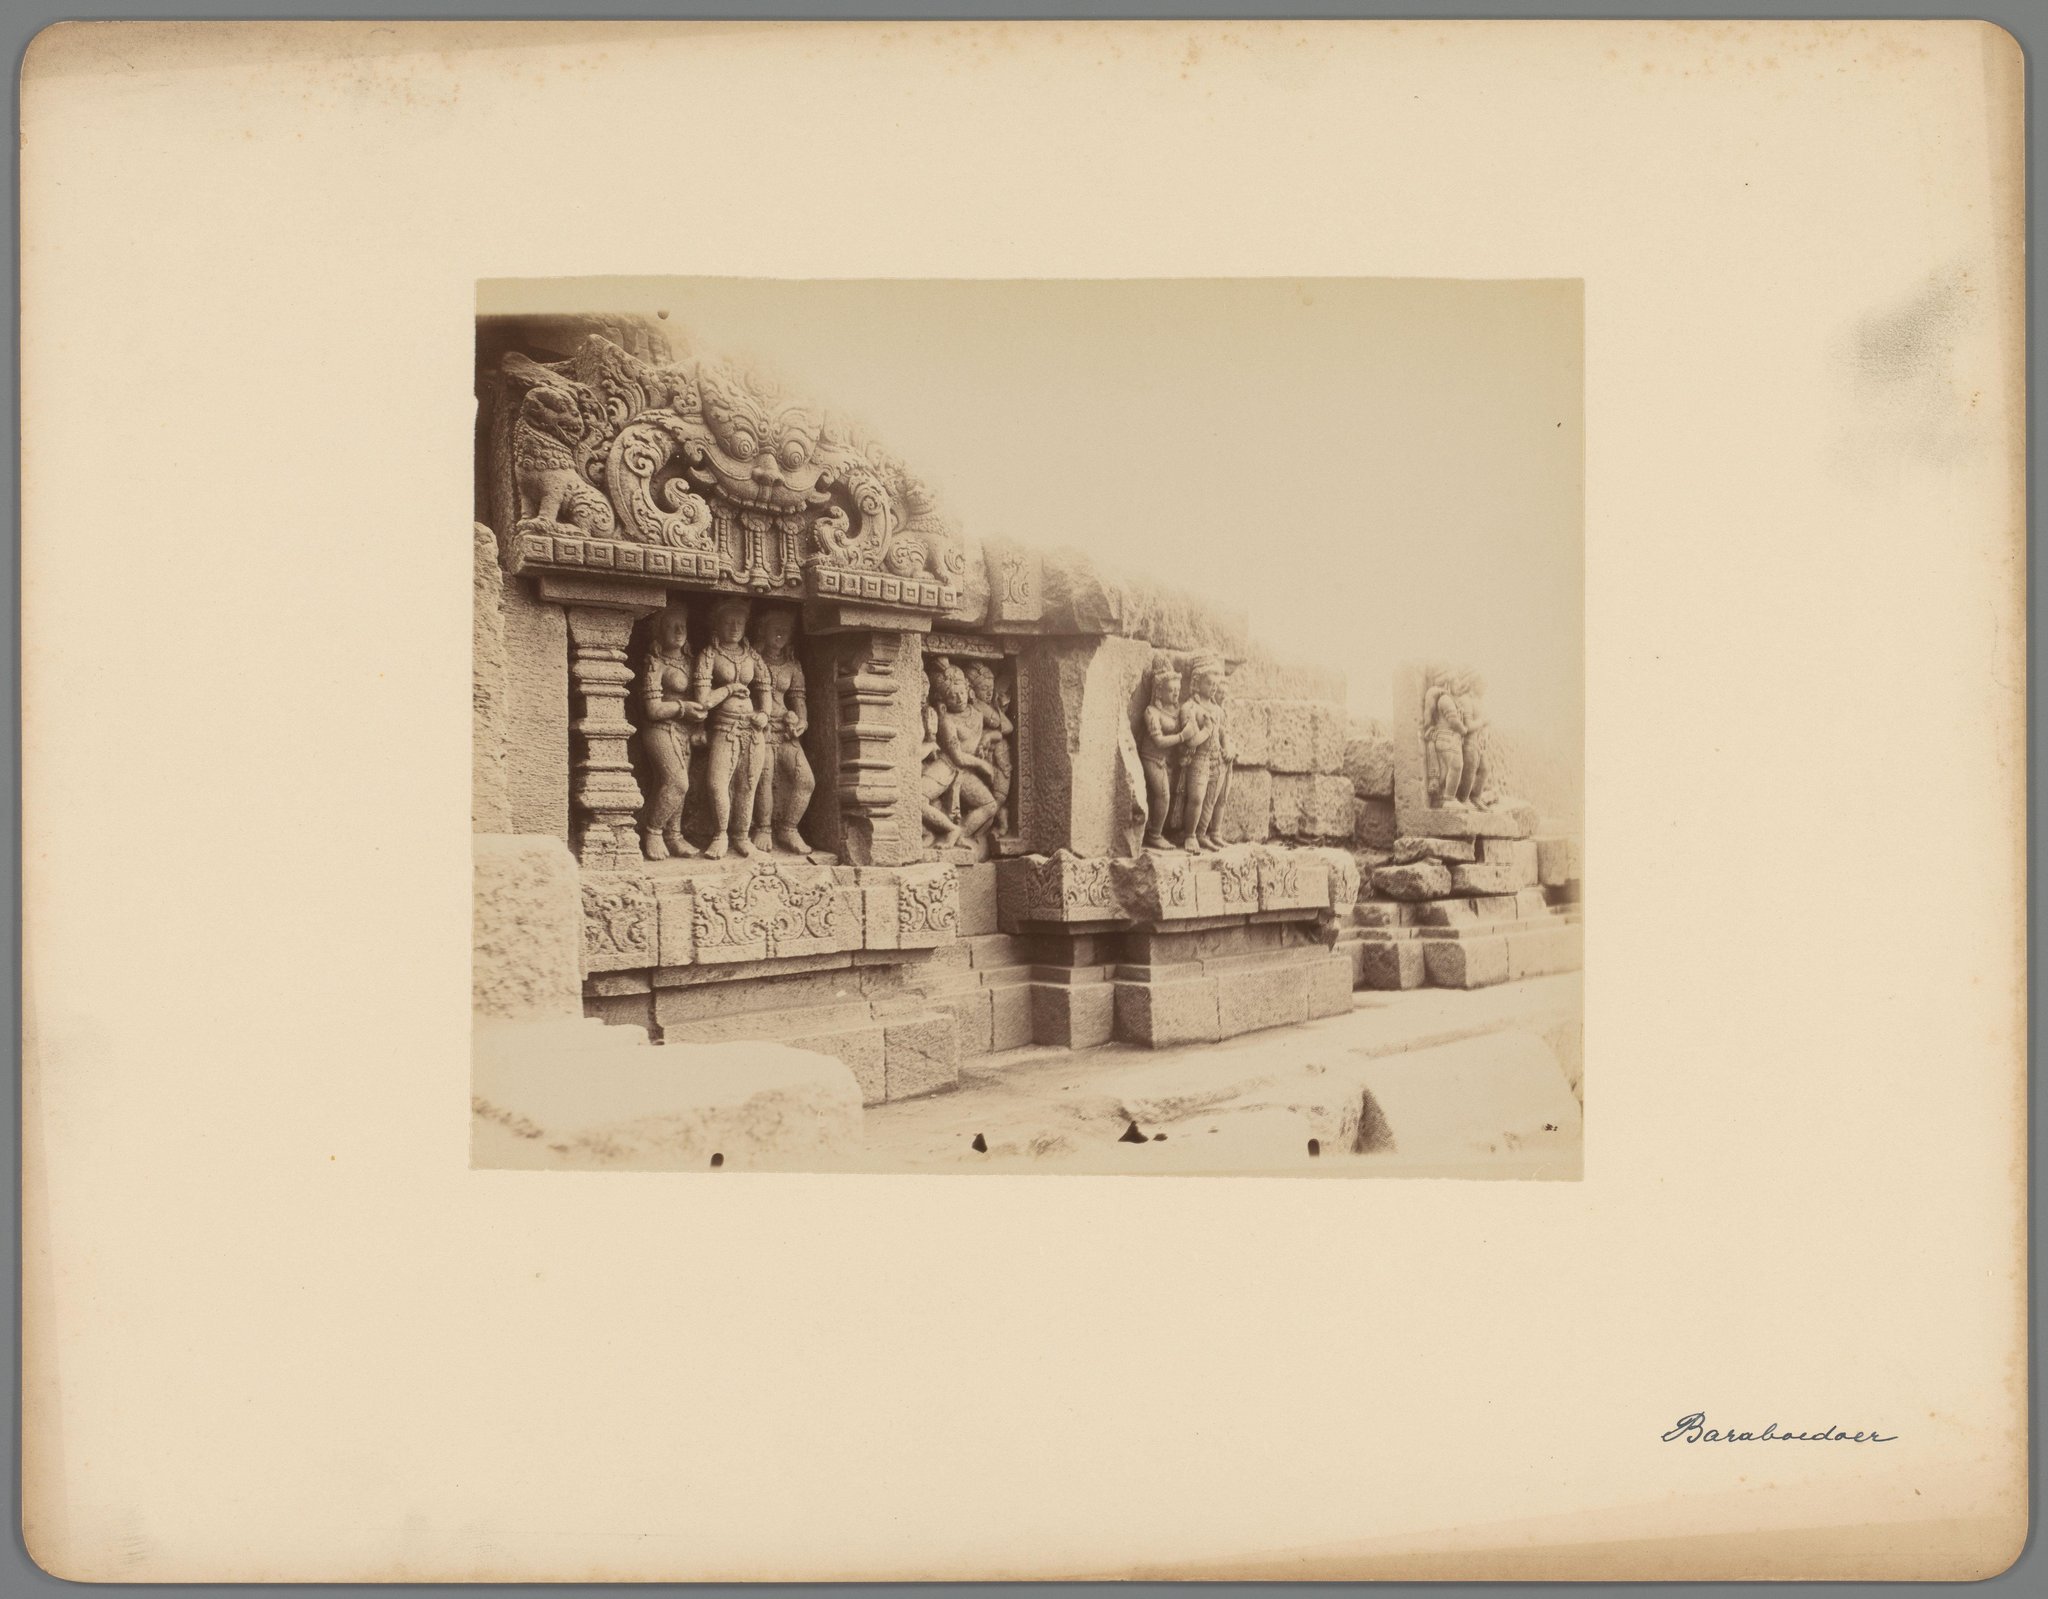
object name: photograph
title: Sculpturen op de Borobudur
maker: kassian céphas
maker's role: fotograaf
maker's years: 1845-1912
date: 1872-1895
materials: cardboard, paper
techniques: albumen print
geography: java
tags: temple, shrine ~ hinduism, buddhism, jainism, piece of sculpture, reproduction of a piece of sculpture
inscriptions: inscription: ‘Foto’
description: Deze foto zat oorspronkelijk in prentenkabinet RP-F-AA3192.